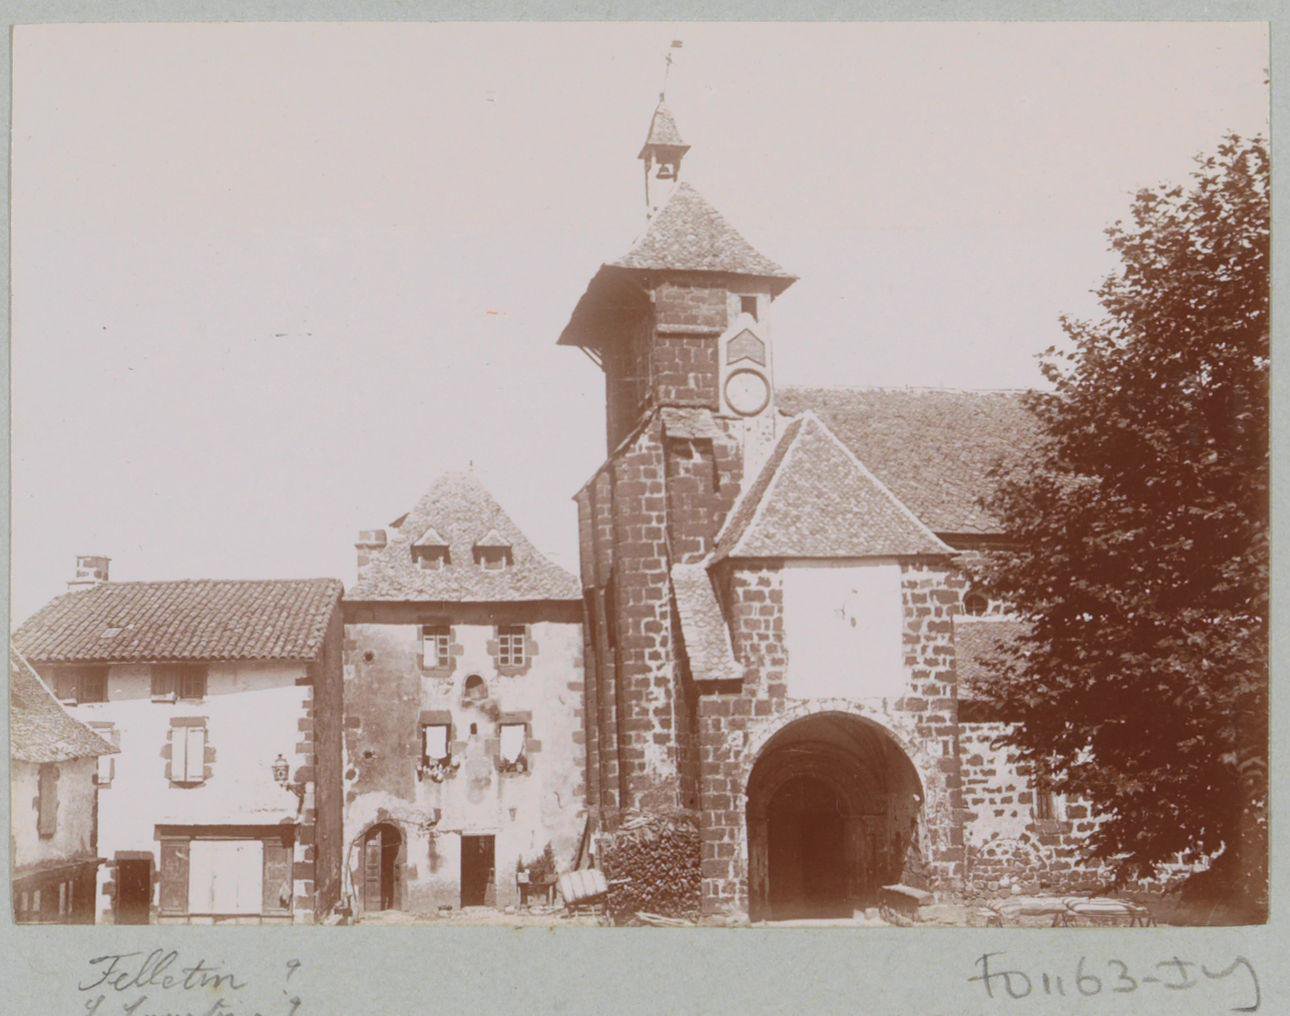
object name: photograph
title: Huizen, poort en toren, vermoedelijk in Midden-Frankrijk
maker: delizy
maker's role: manufacturer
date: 1899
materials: paper, photographic support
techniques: gelatin silver print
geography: france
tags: rural housing, e.g. country-house, villa, cottage, france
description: Onderdeel van Fotoalbum van een Franse amateurfotograaf met opnames van uitstapjes in Frankrijk, Spanje, België, Luxemburg en Nederland, de eerste automobielen en autoraces.